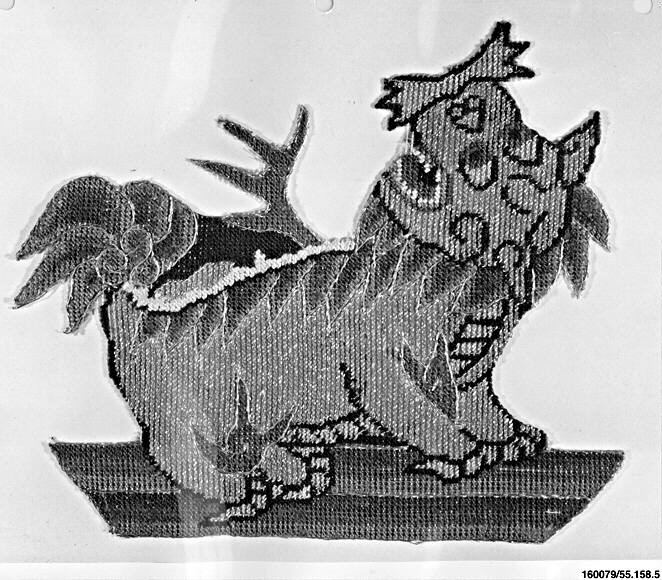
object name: appliqué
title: Applique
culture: chinese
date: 1867-1933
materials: metal thread, silk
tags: animals